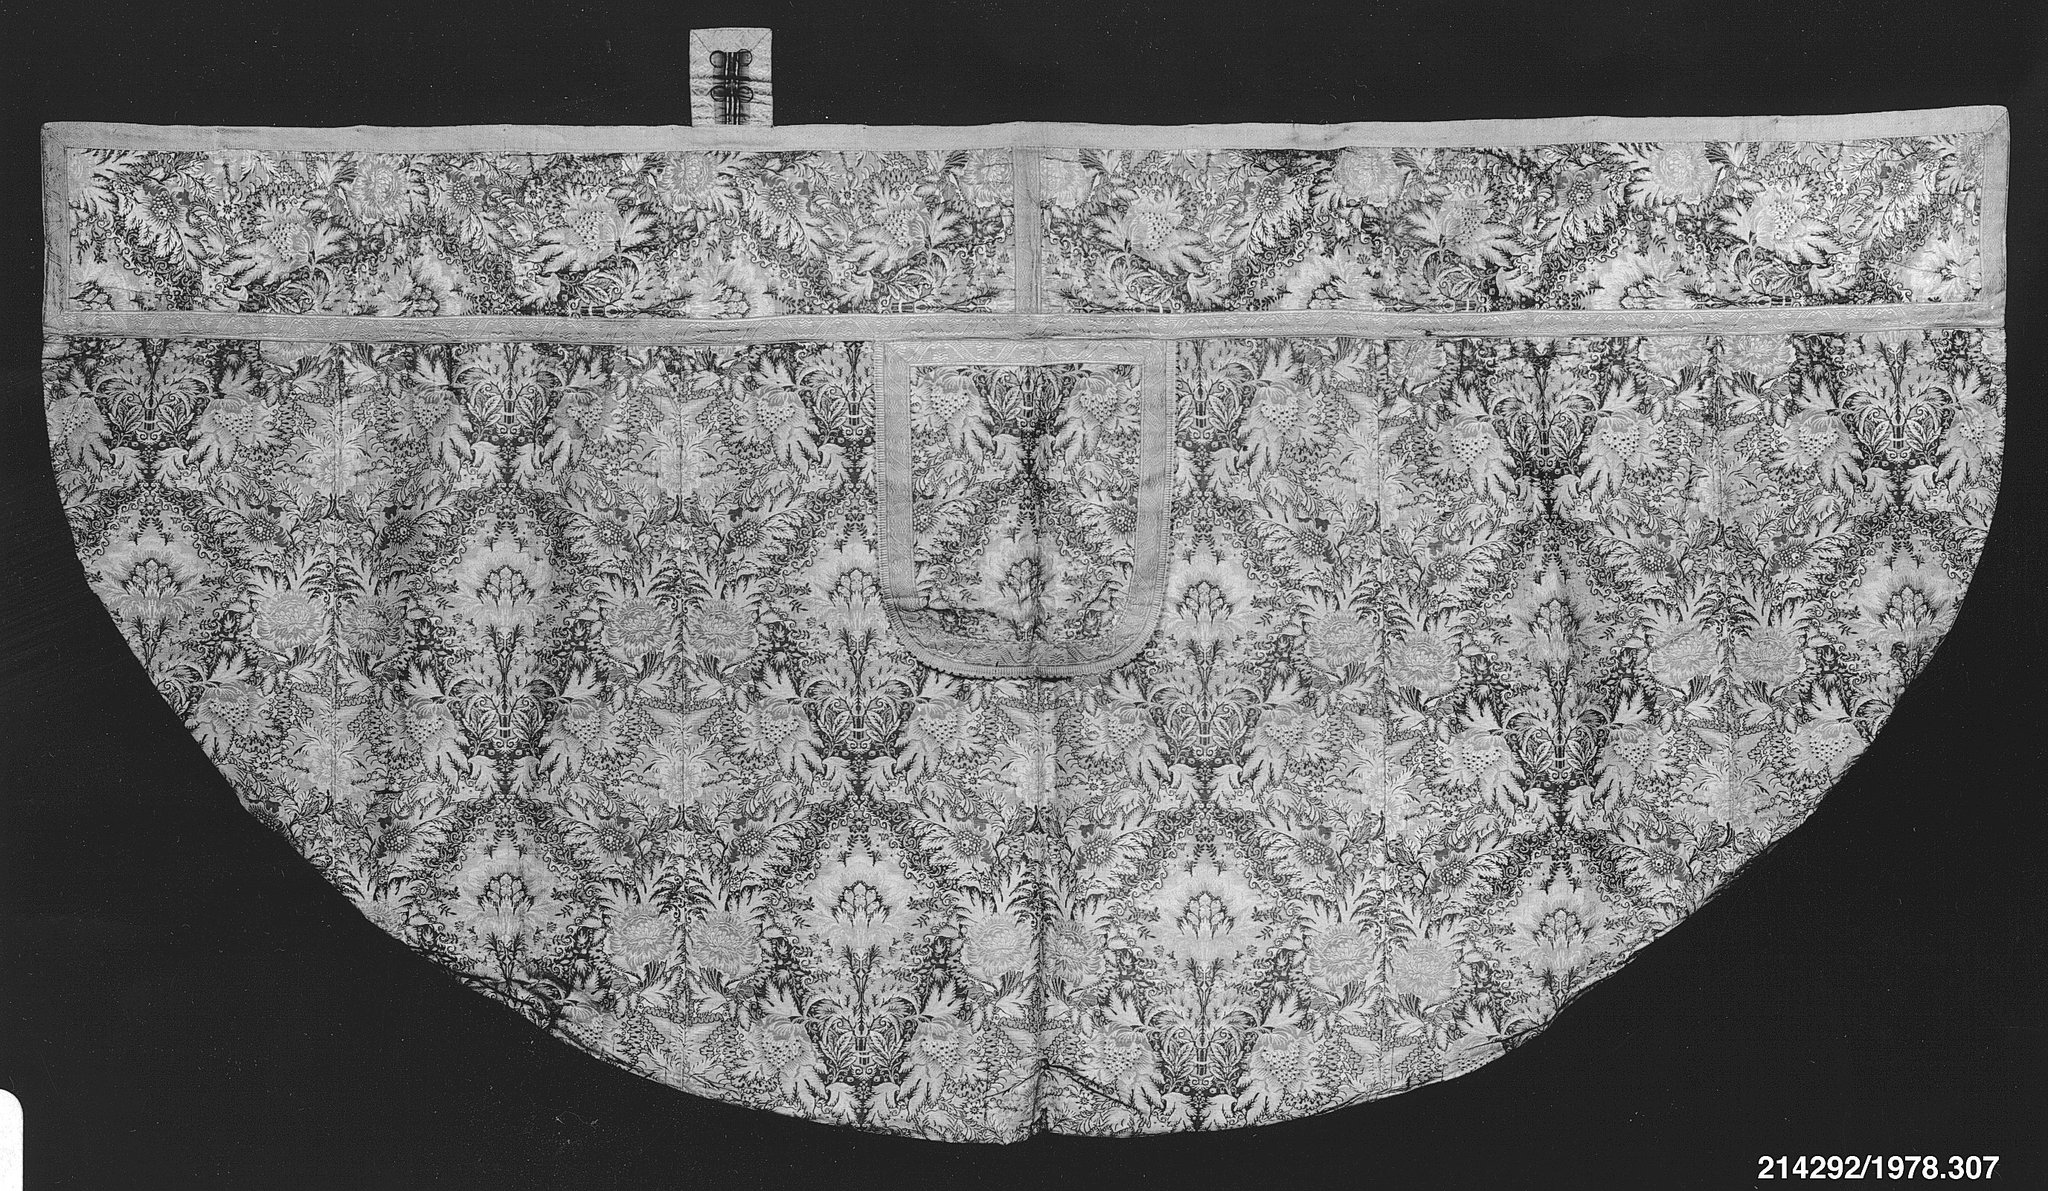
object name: cope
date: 1701-1800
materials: metal thread, silk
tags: flowers